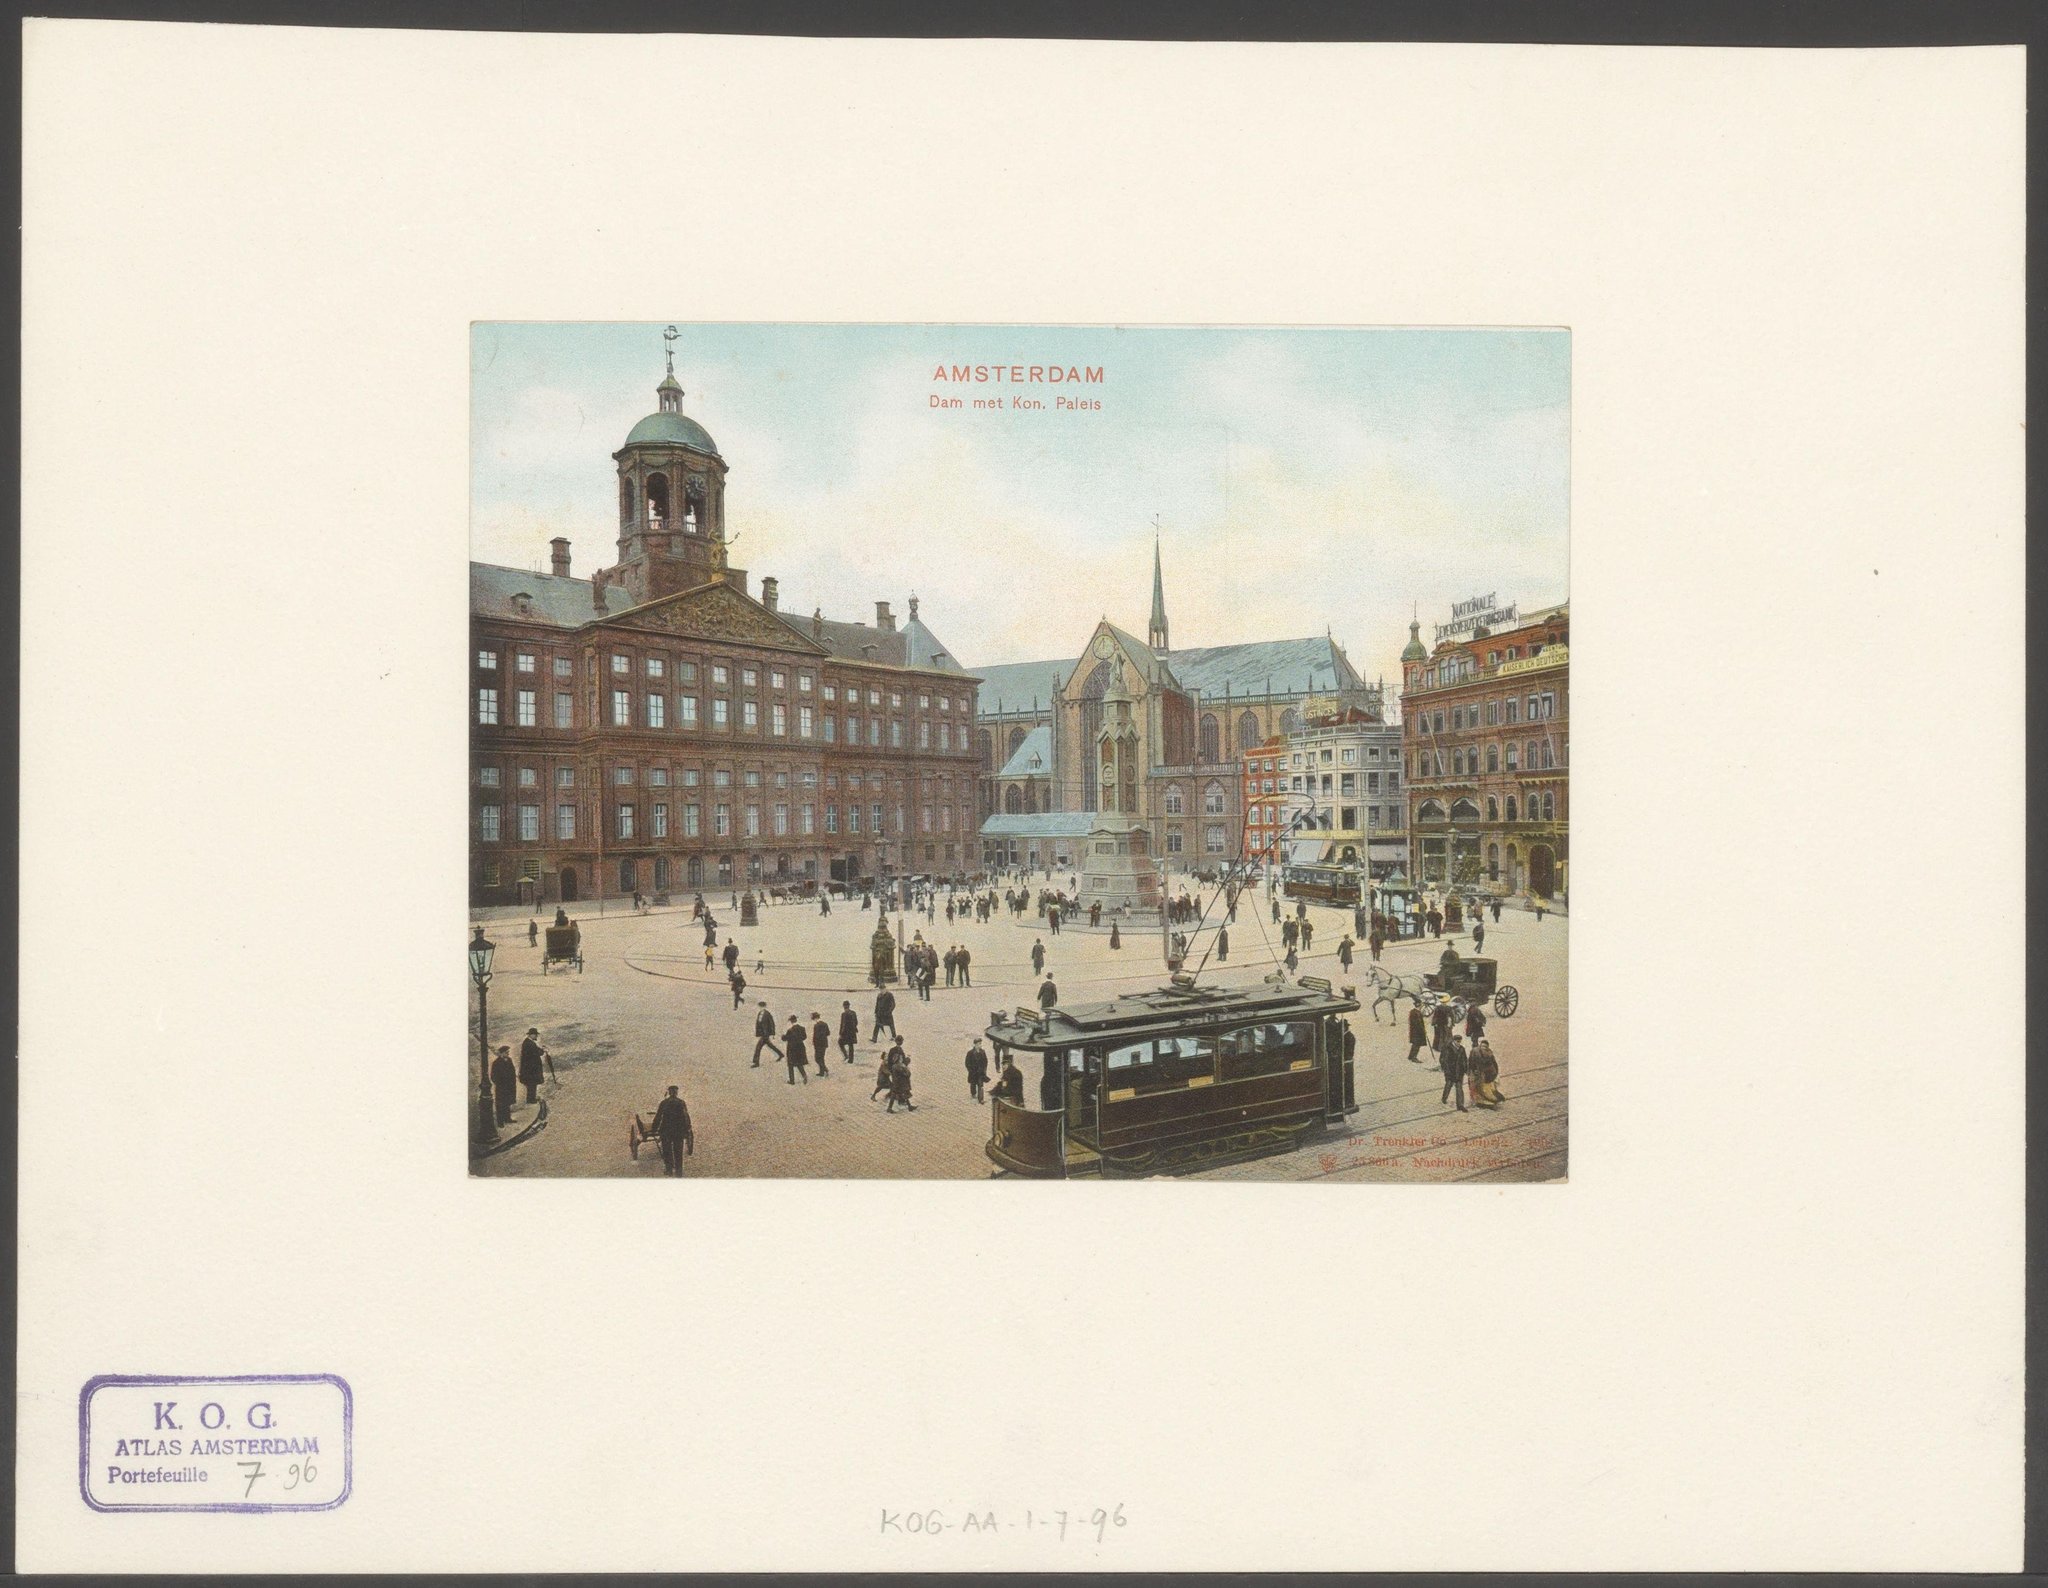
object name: photomechanical print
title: Gezicht op het Koninklijk Paleis op de Dam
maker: Anonymous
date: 1909-1918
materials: cardboard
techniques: lithograph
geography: amsterdam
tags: square, place, circus, etc., city-view in general; 'veduta', palace, church (exterior), royal palace of amsterdam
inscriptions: collector's mark: ‘7’ Lugt 1641b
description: Onderwerpsrubriek binnen de Atlas Amsterdam: Dam (na 1835).